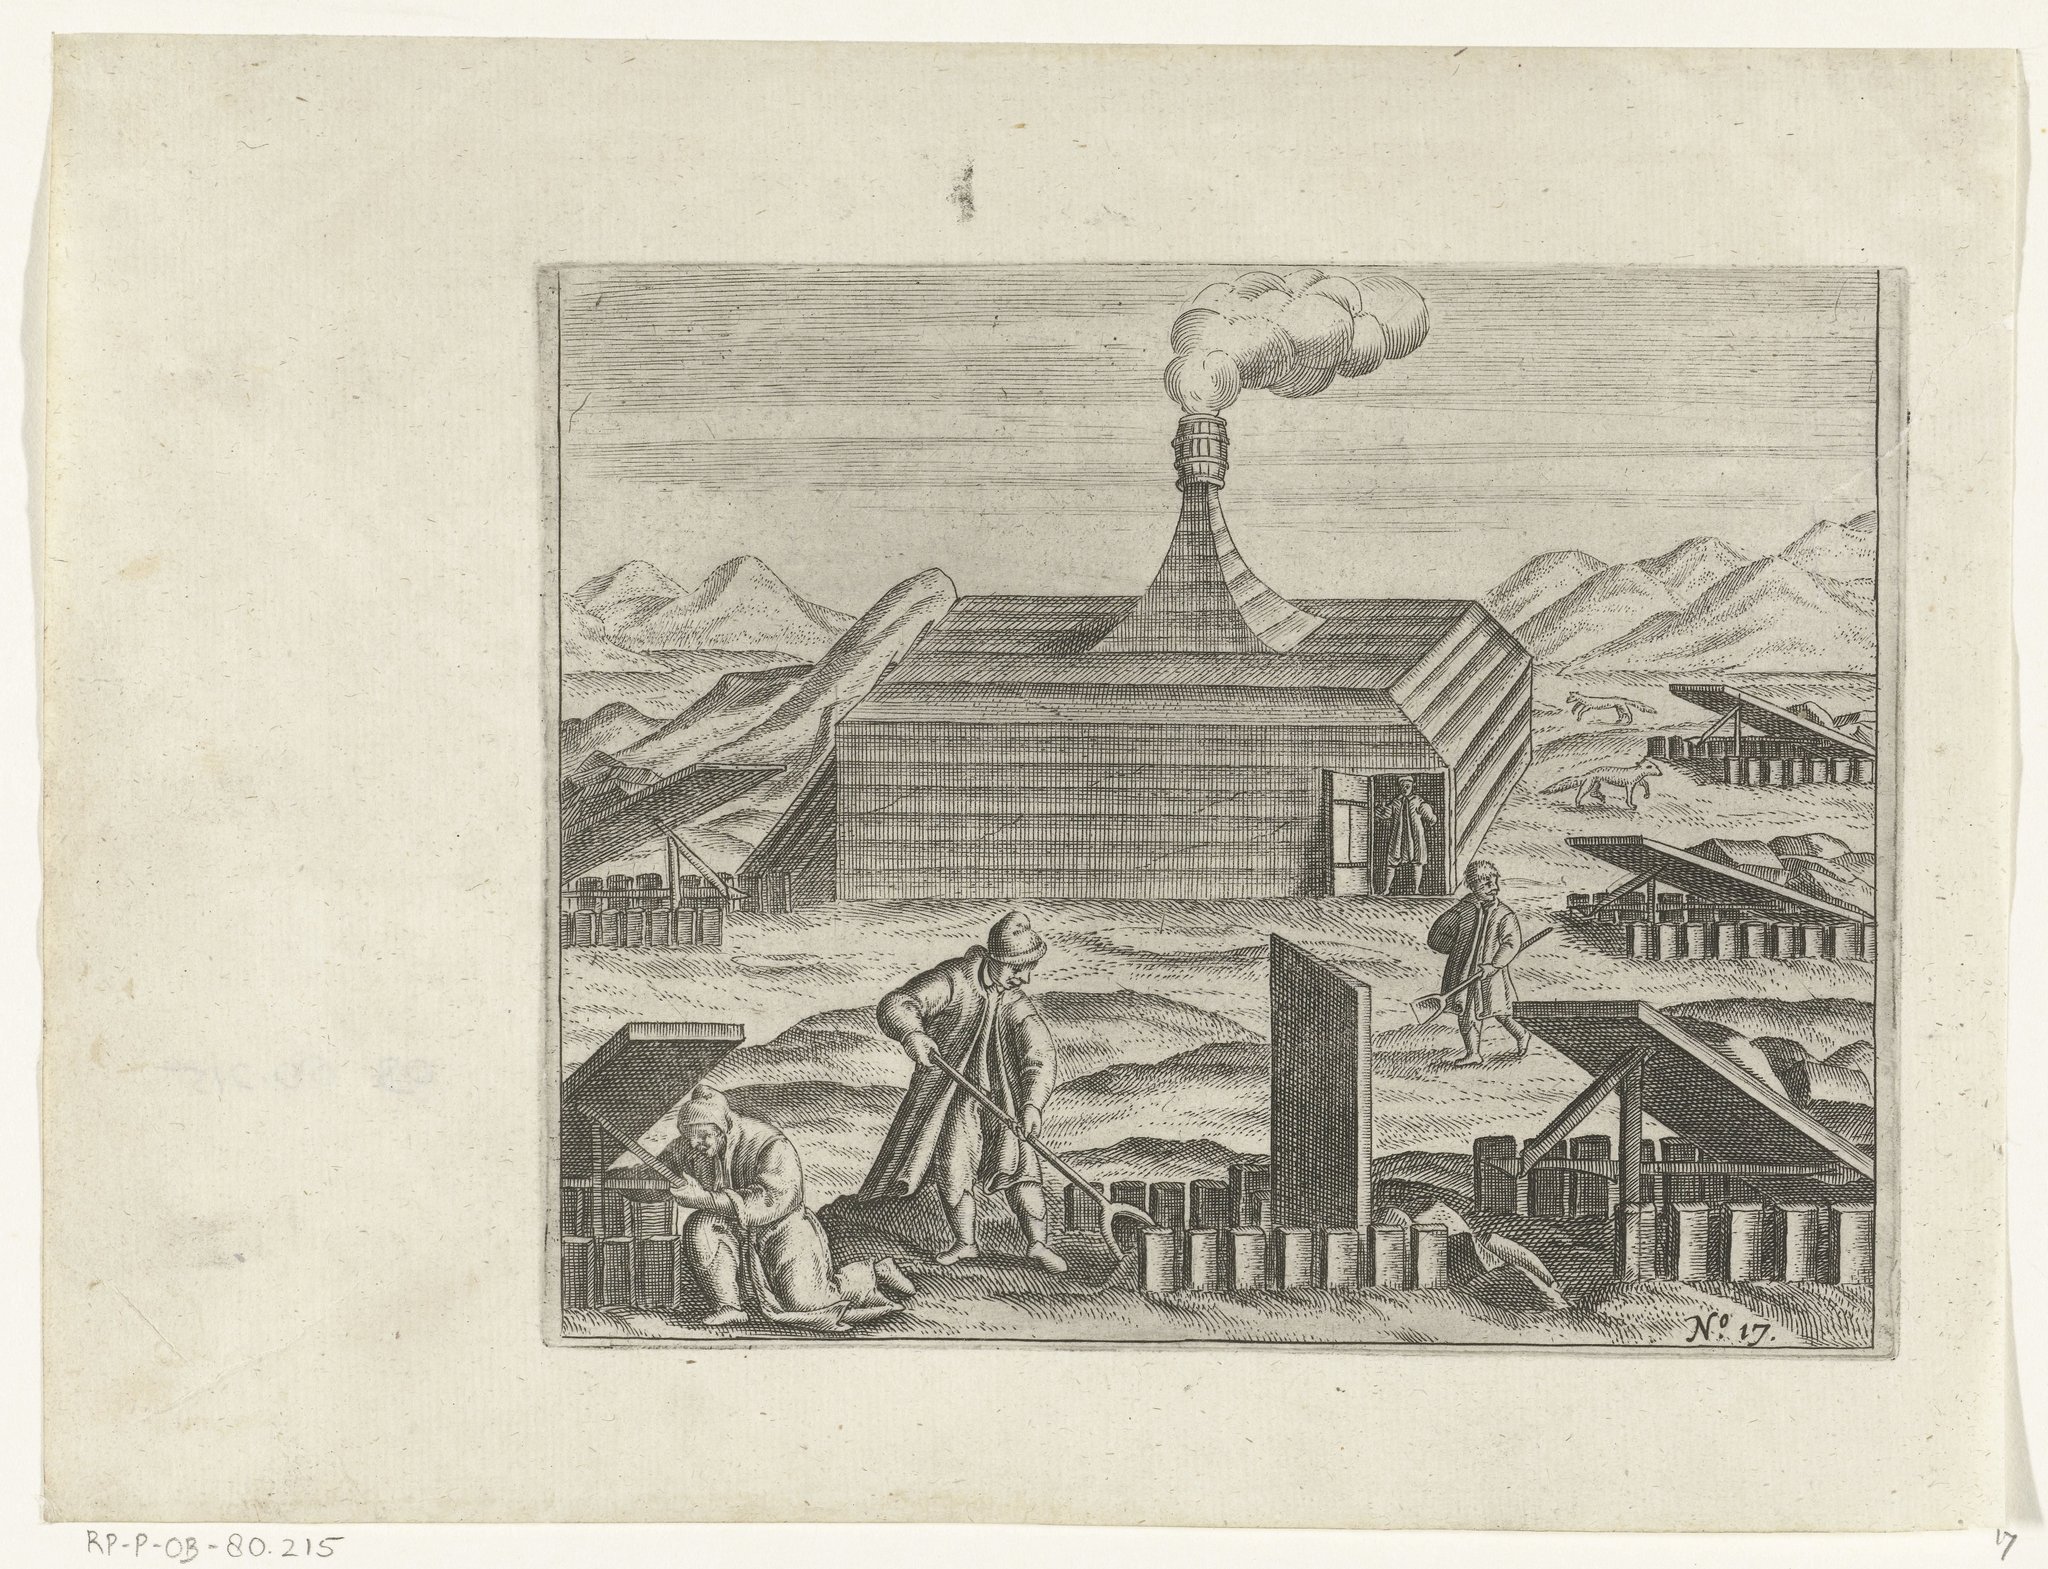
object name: print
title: Aanleggen van vossenvallen bij het Behouden Huys, 1596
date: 1615-1617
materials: paper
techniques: engraving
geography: northern netherlands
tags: willem barendsz., amsterdam, jacob van heemskerck, sports, games ~ animals (+ trap), landscapes in polar regions, exploration, expedition, voyage of discovery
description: Gebruikt als illustratie eerst in: G. de Veer, De waerachtige beschrijvinge vande drie seylagien, drie jaren achter mal-kanderen deur de Hollandtsche ende Zeelandtsche Schepen, by noorden Noorweghen, Moscovien ende tartarien nae de Coninckrijcken van Catthay ende China ghedaene, [Michiel Colijn, Amsterdam 1617]. Later gebruikt in: Kort verhael van d'eerste Schipvaerd der Hollandsche ende Zeeusche Schepen by noorden Noorwegen, Moscovien ende Tartarien om, nae de Coningrijcken van Cathay ende China, getogen uyt het Journael van Gerrit de Veer. Opgenomen in: I. Commelin, Begin ende voortgangh, van de Vereenighde Nederlantsche Geoctroyeerde Oost-Indische Compagnie, J. Janssonius, Amsterdam 1646. Genummerd: No. 17.